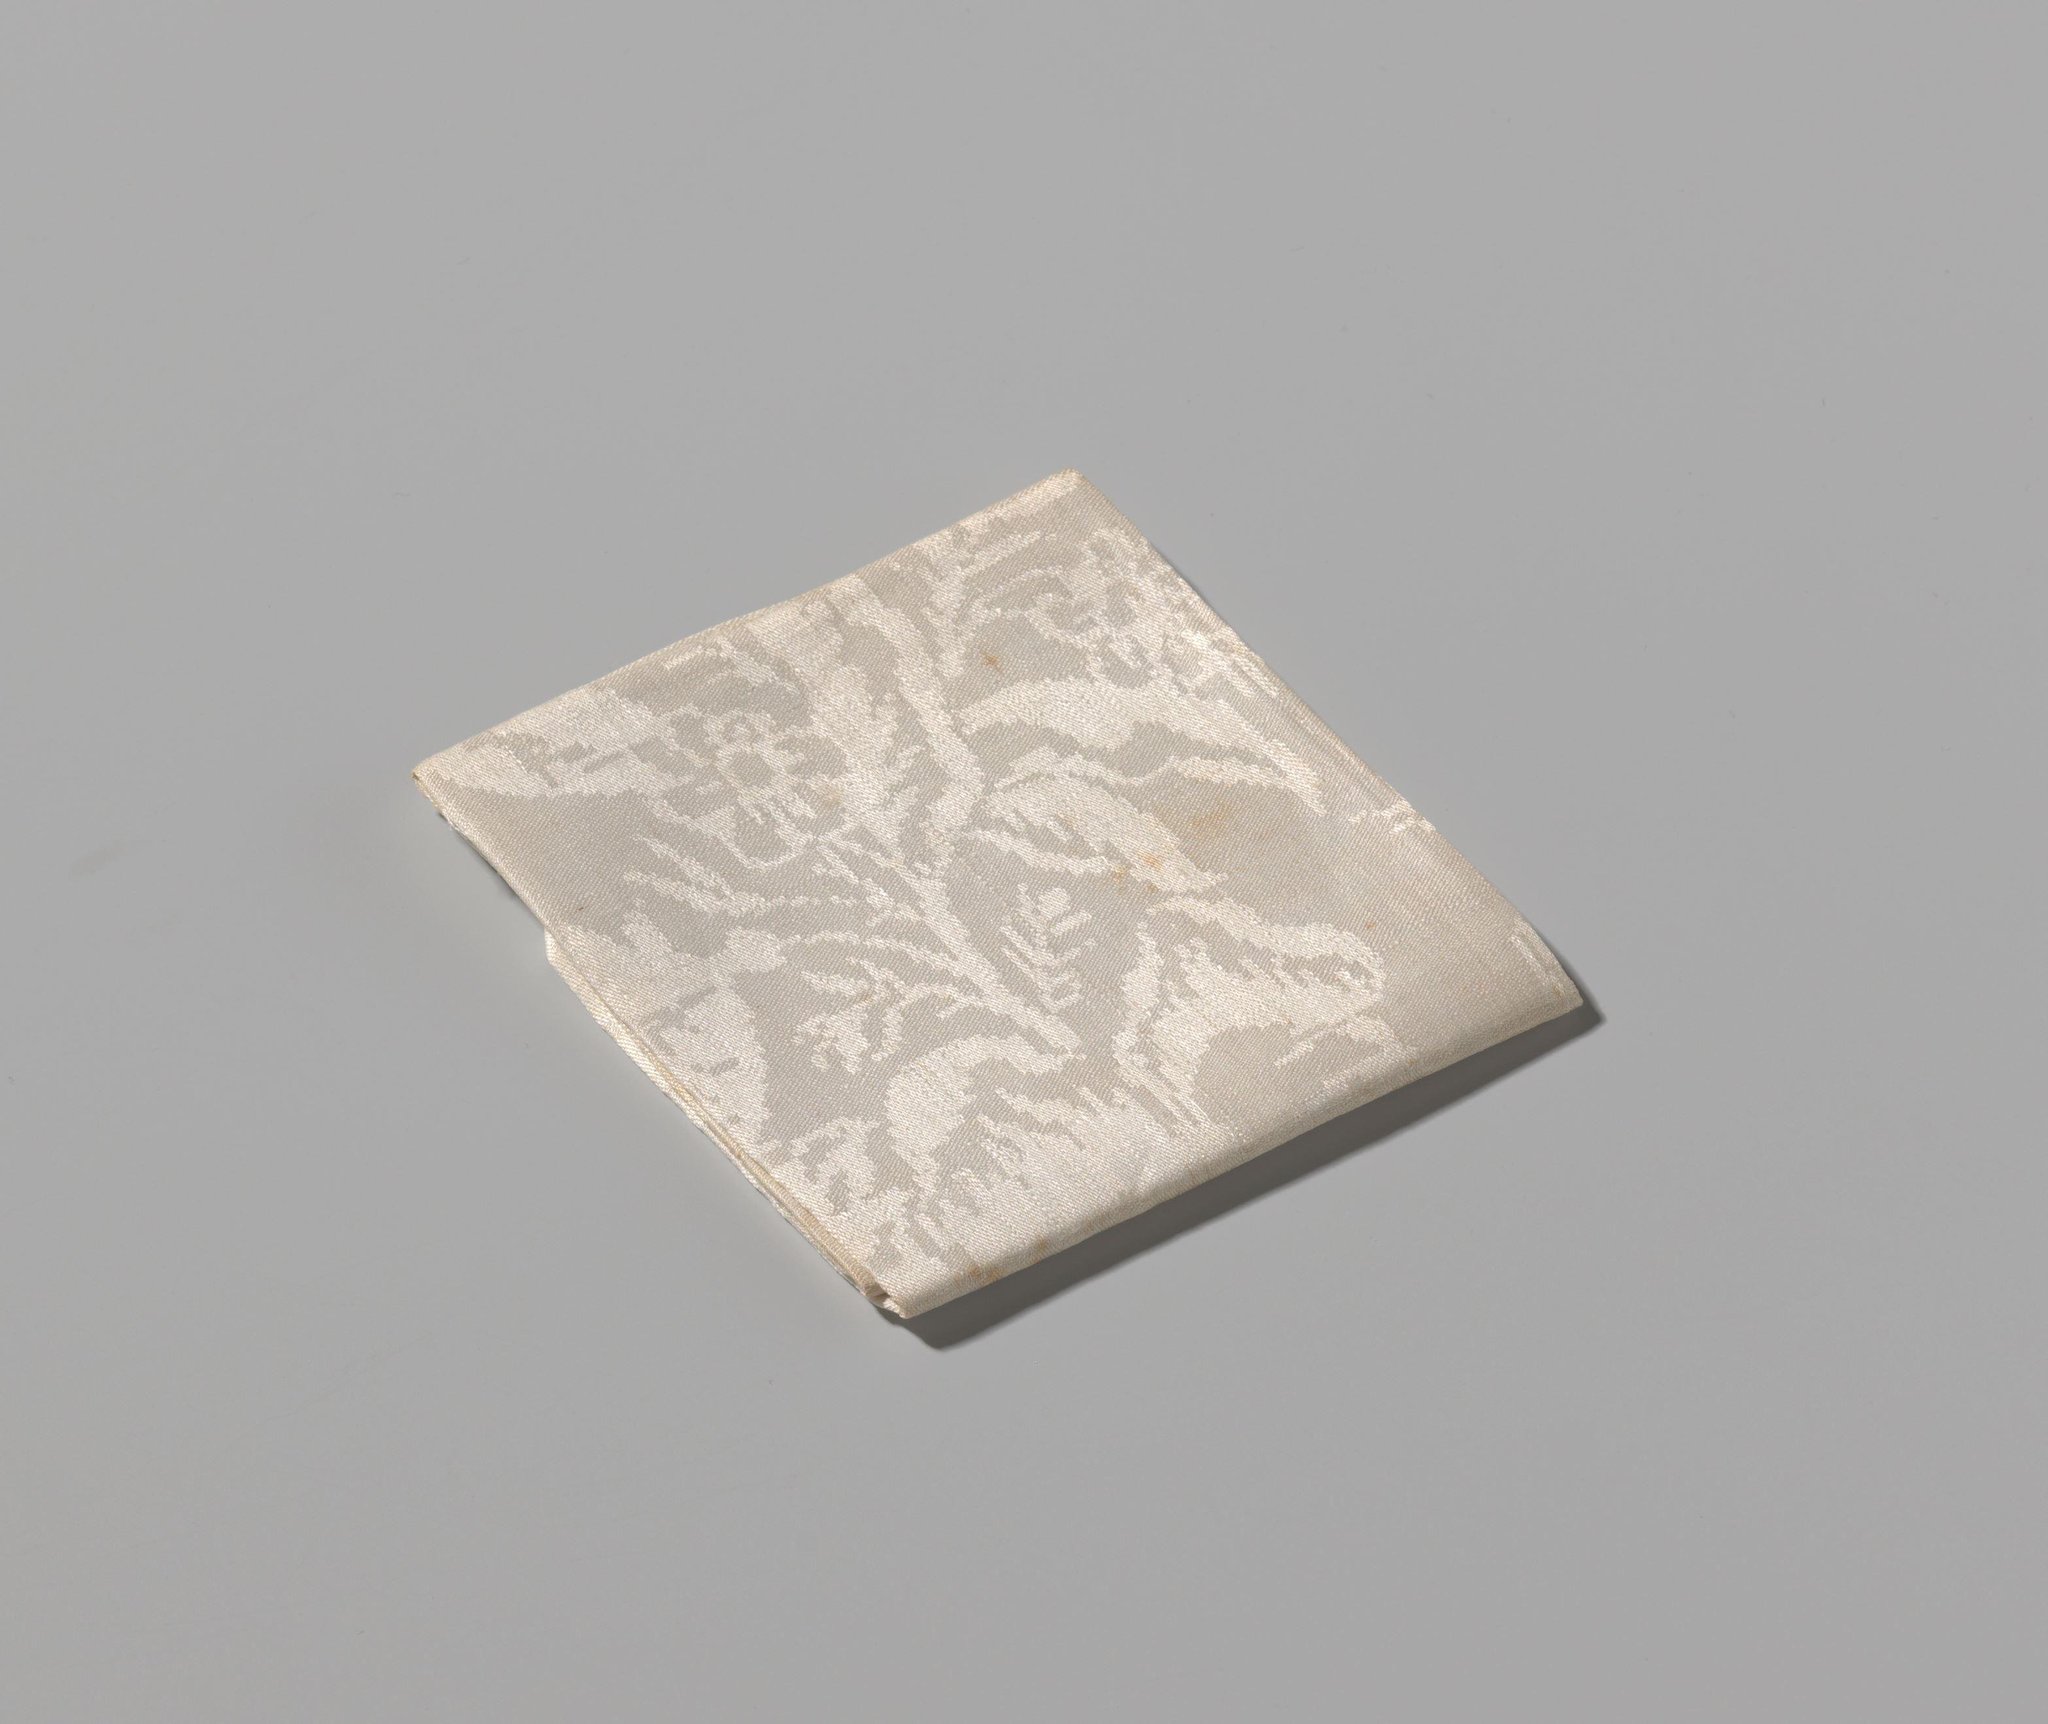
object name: napkin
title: Fragment van een servet van wit linnendamast met een patroon van een bloeiende tak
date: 1730-1740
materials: linen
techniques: damask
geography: flanders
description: Fragment van een servet van wit linnendamast met een patroon van een bloeiende tak.